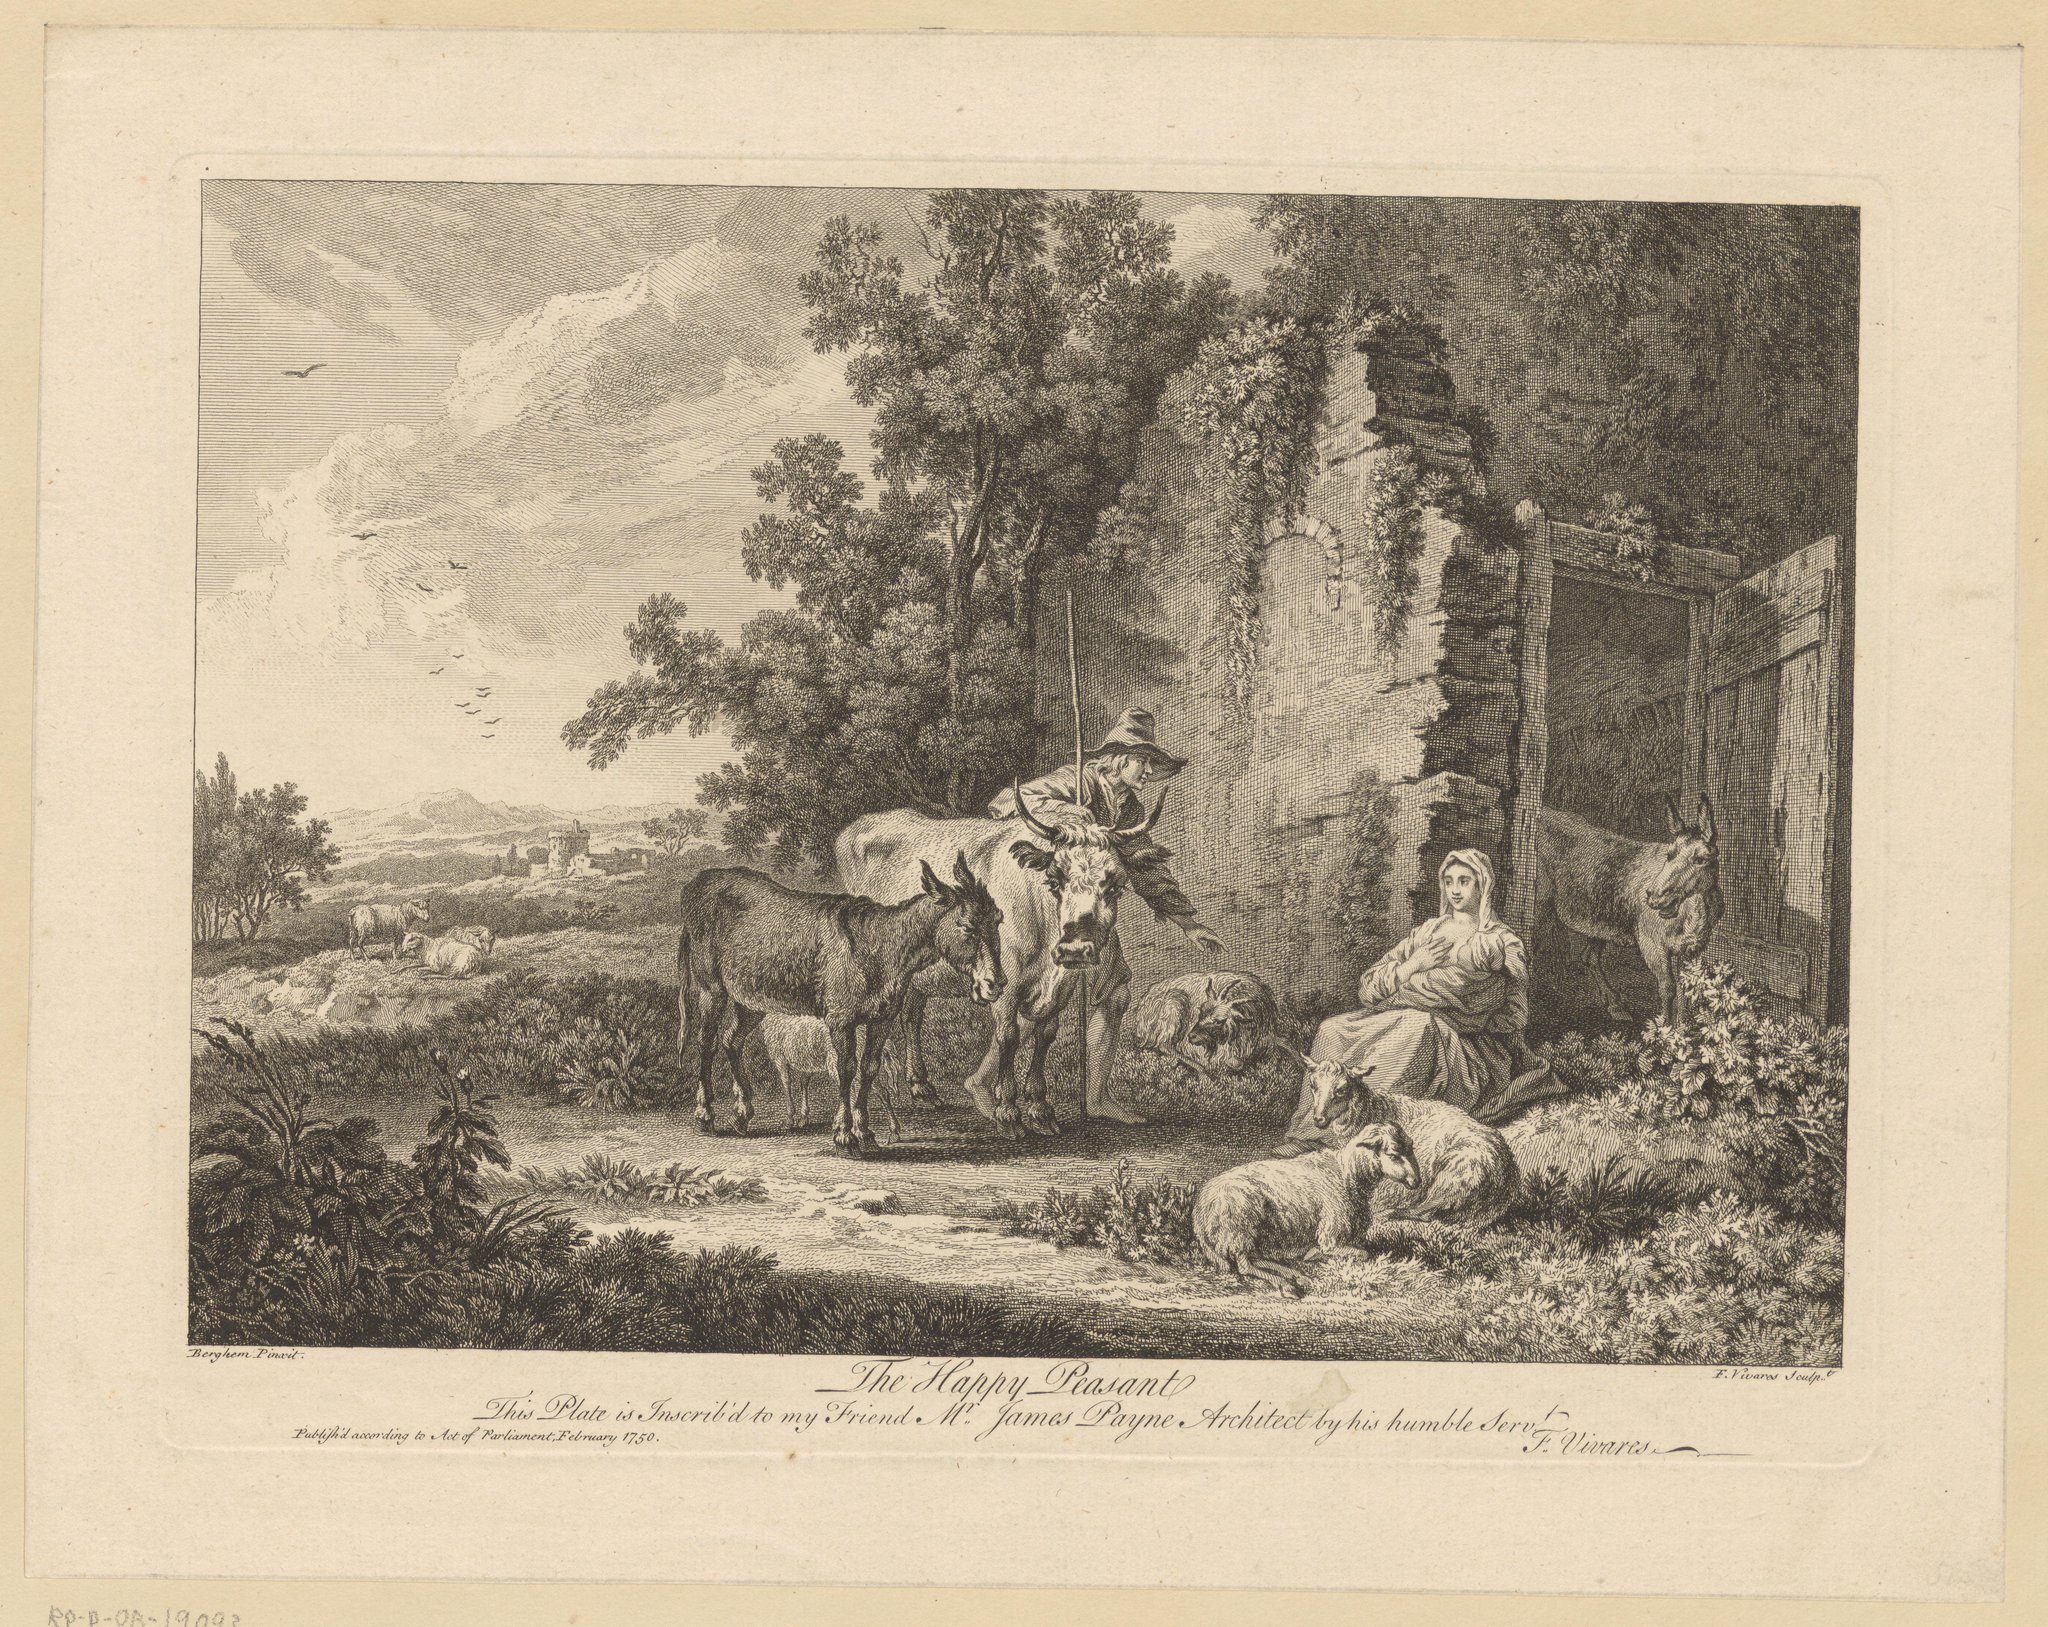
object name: print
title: The Happy Peasant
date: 1750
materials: paper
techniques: etching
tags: nursing, suckling, herding, herdsman, herdswoman, shepherd, shepherdess, cowherd, etc., cattle, low hill country (+ landscape with figures, staffage)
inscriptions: collector's mark: Lugt 240